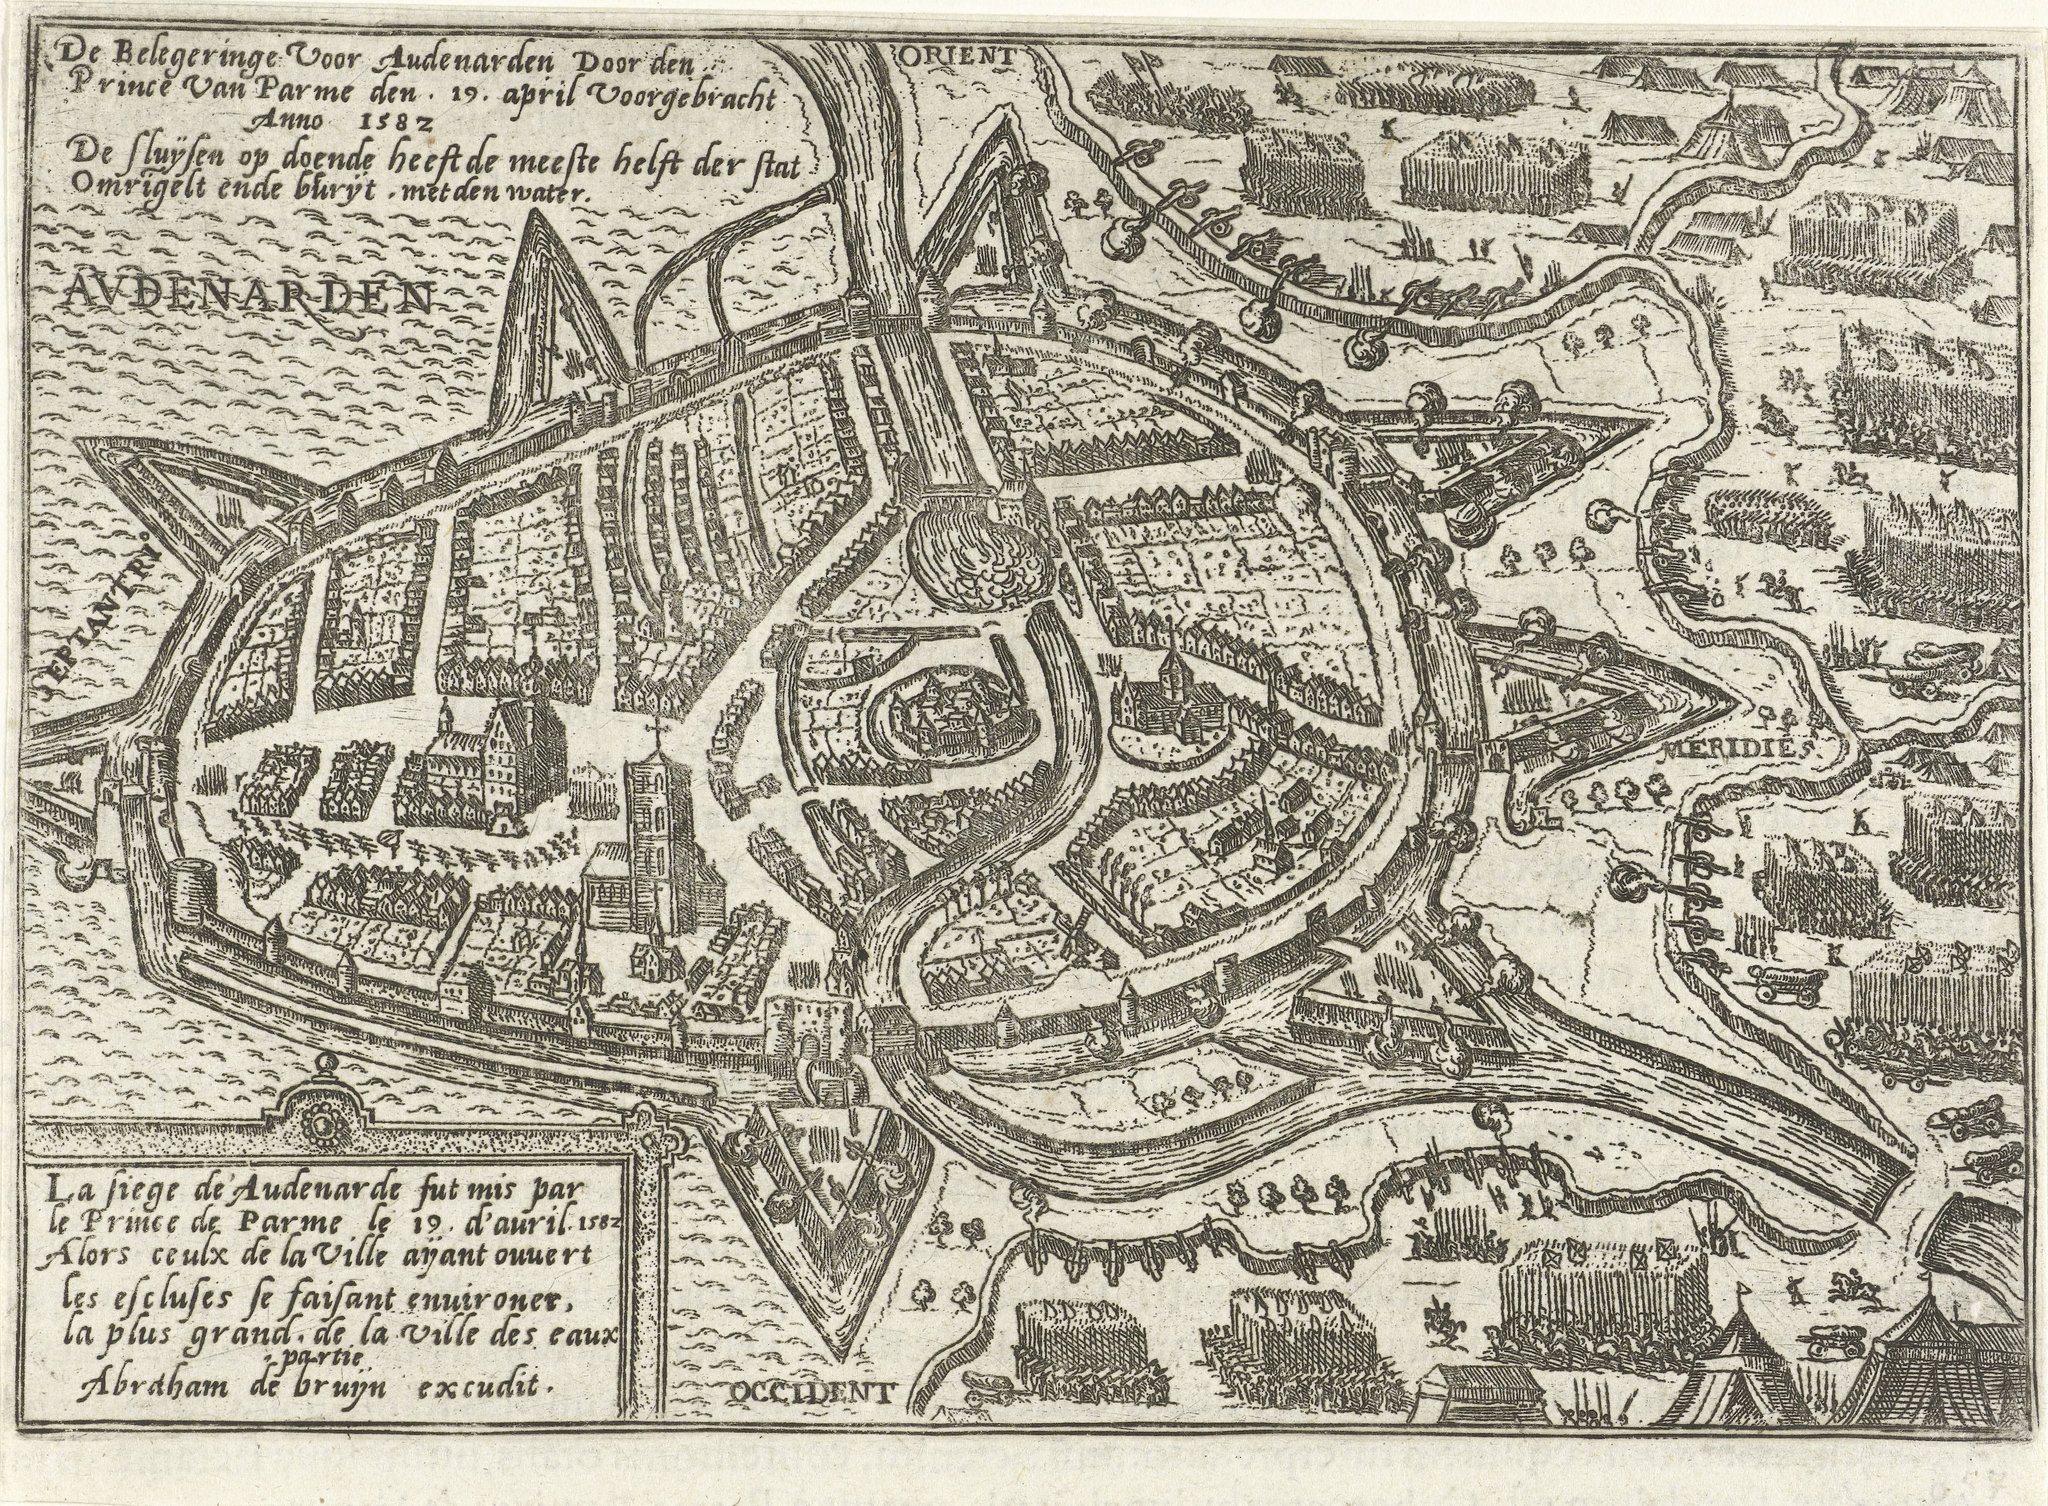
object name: history print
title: Parma belegert en verovert Oudenaarde, 1582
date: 1613-1615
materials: paper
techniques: etching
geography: northern netherlands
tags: siege, position war, capture of city (after the siege)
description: Beleg en inname van Oudenaarde door het leger van de hertog van Parma, 19 april tot 5 juli 1582. Linksboven opschrift van 5 regels in het Nederlands, linksonder in cartouche 5 regels in het Frans. Ongenummerd. Bedrukt op achterzijde met tekst in het Latijn.